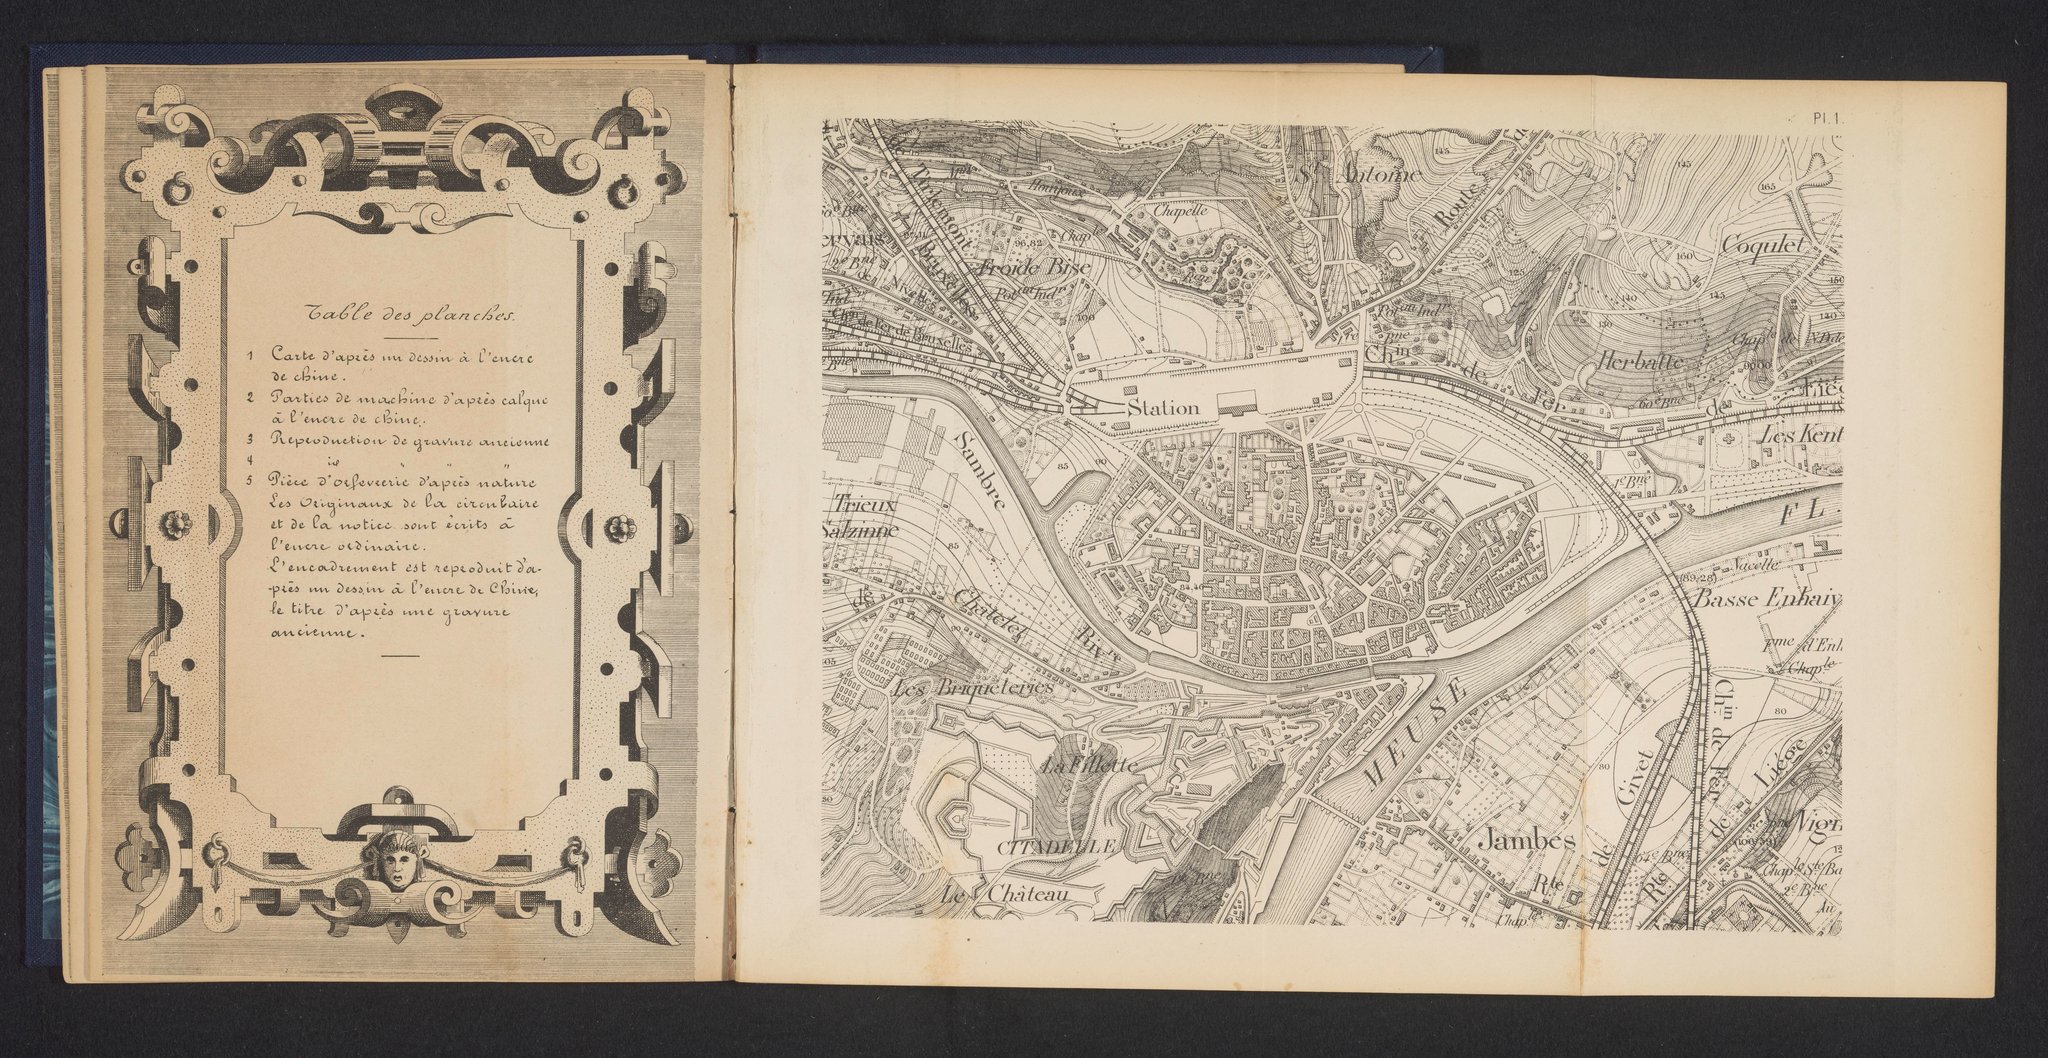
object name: page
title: Reproductie van een kaart van Namur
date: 1868-1873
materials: paper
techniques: photolithography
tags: maps of cities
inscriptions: number: ‘Pl. 1.’